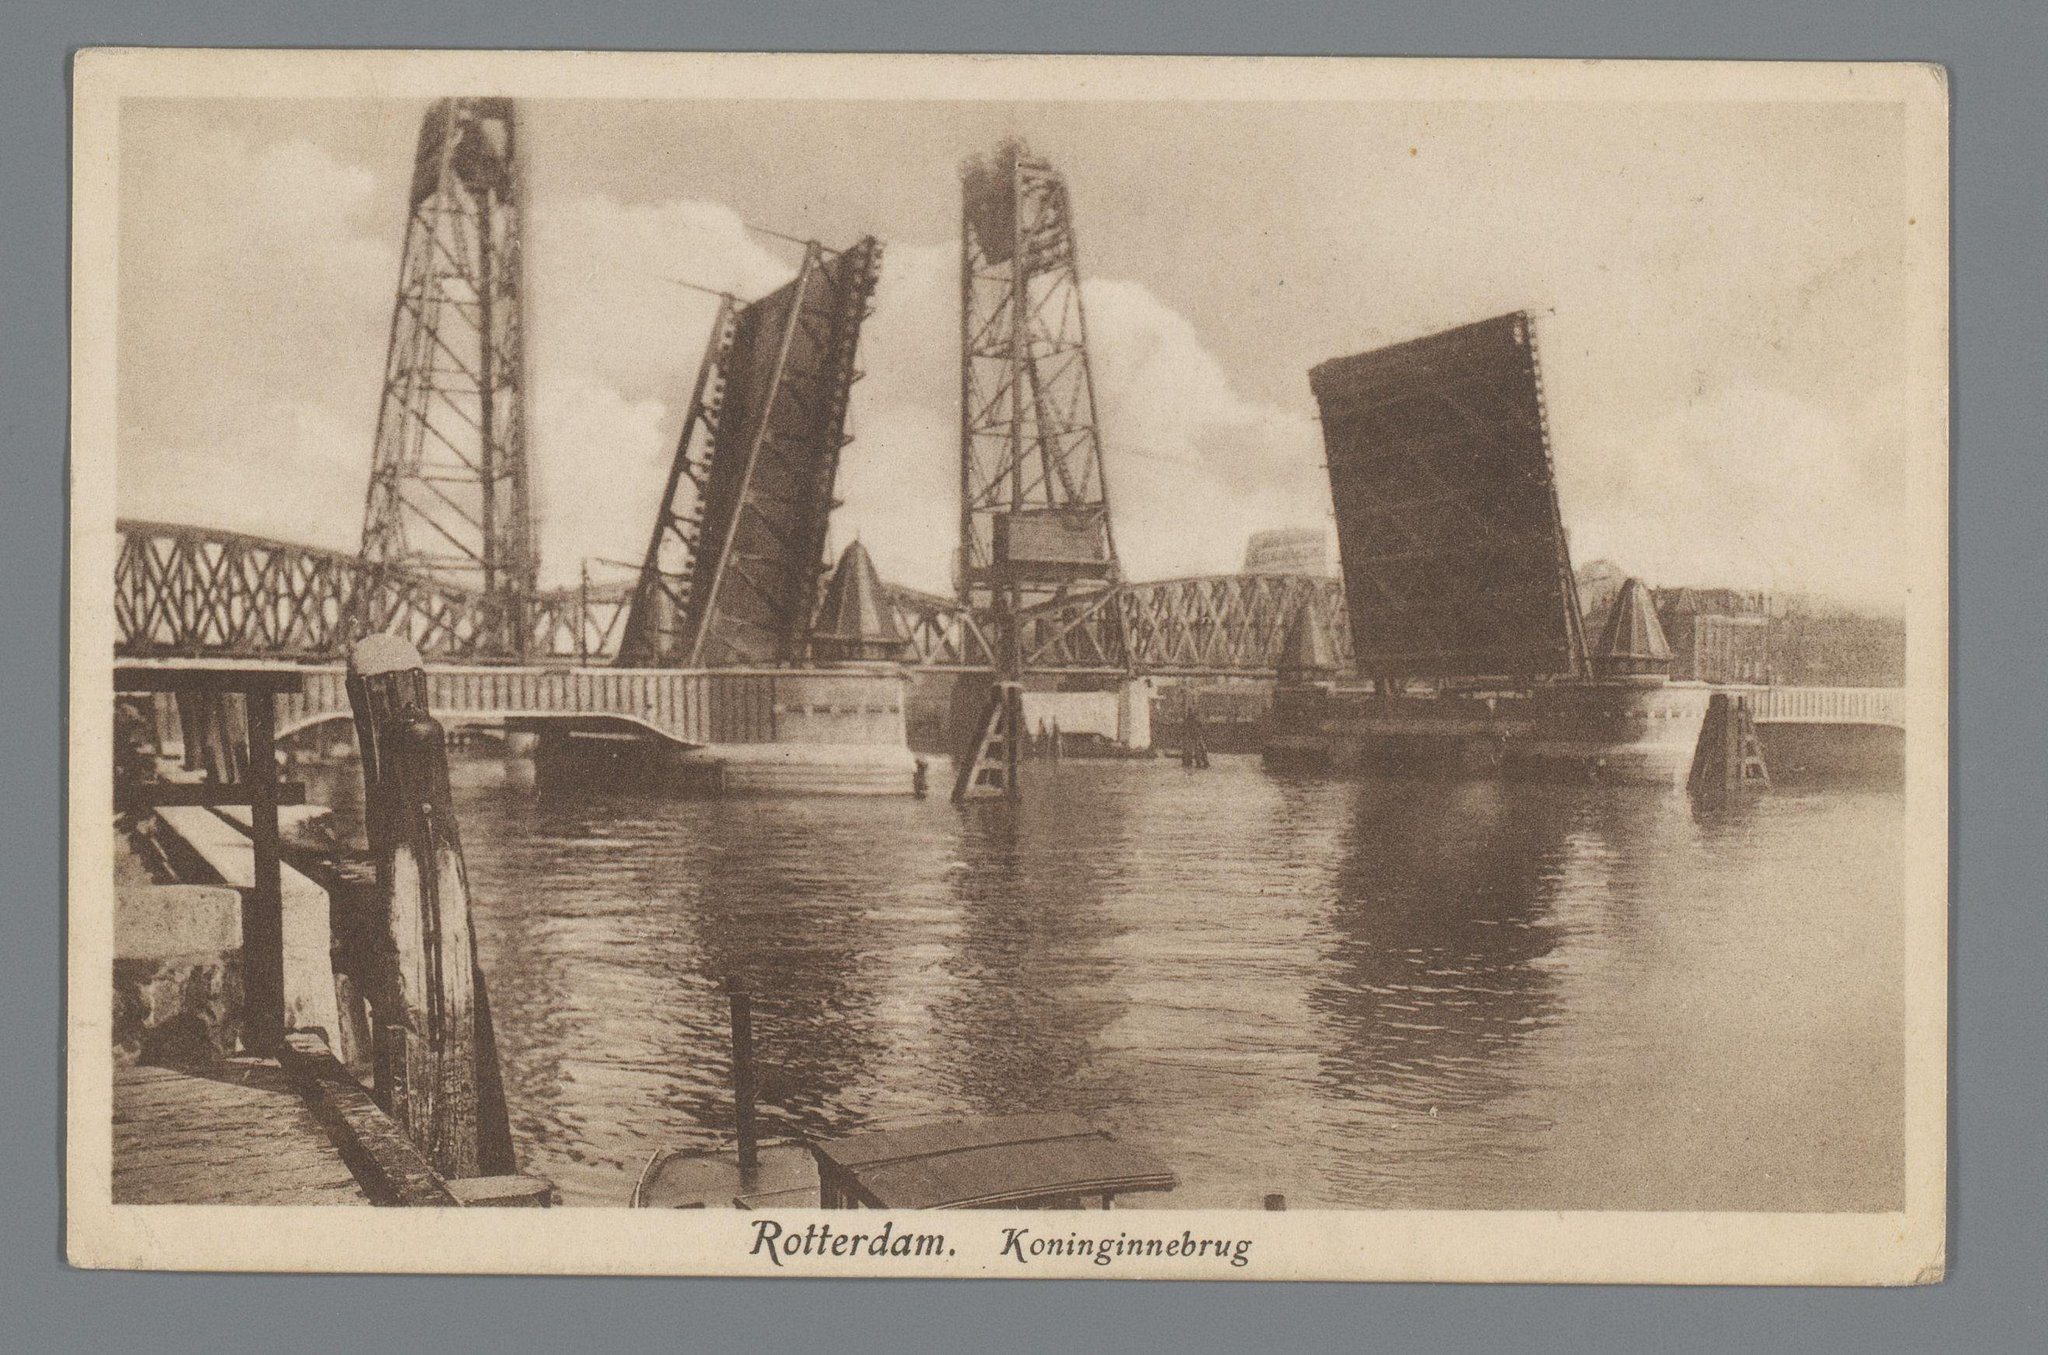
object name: ansichtkaart, prentbriefkaart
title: Rotterdam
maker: Anonymous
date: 1929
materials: paper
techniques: photograph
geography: the hague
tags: bridge in city across river, canal, etc., rotterdam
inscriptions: inscription: ‘aan de [...] frater/ Andreas Wimsinghoff/ 16tie "St. Matthias."/ Trier./ (Duitschland)’